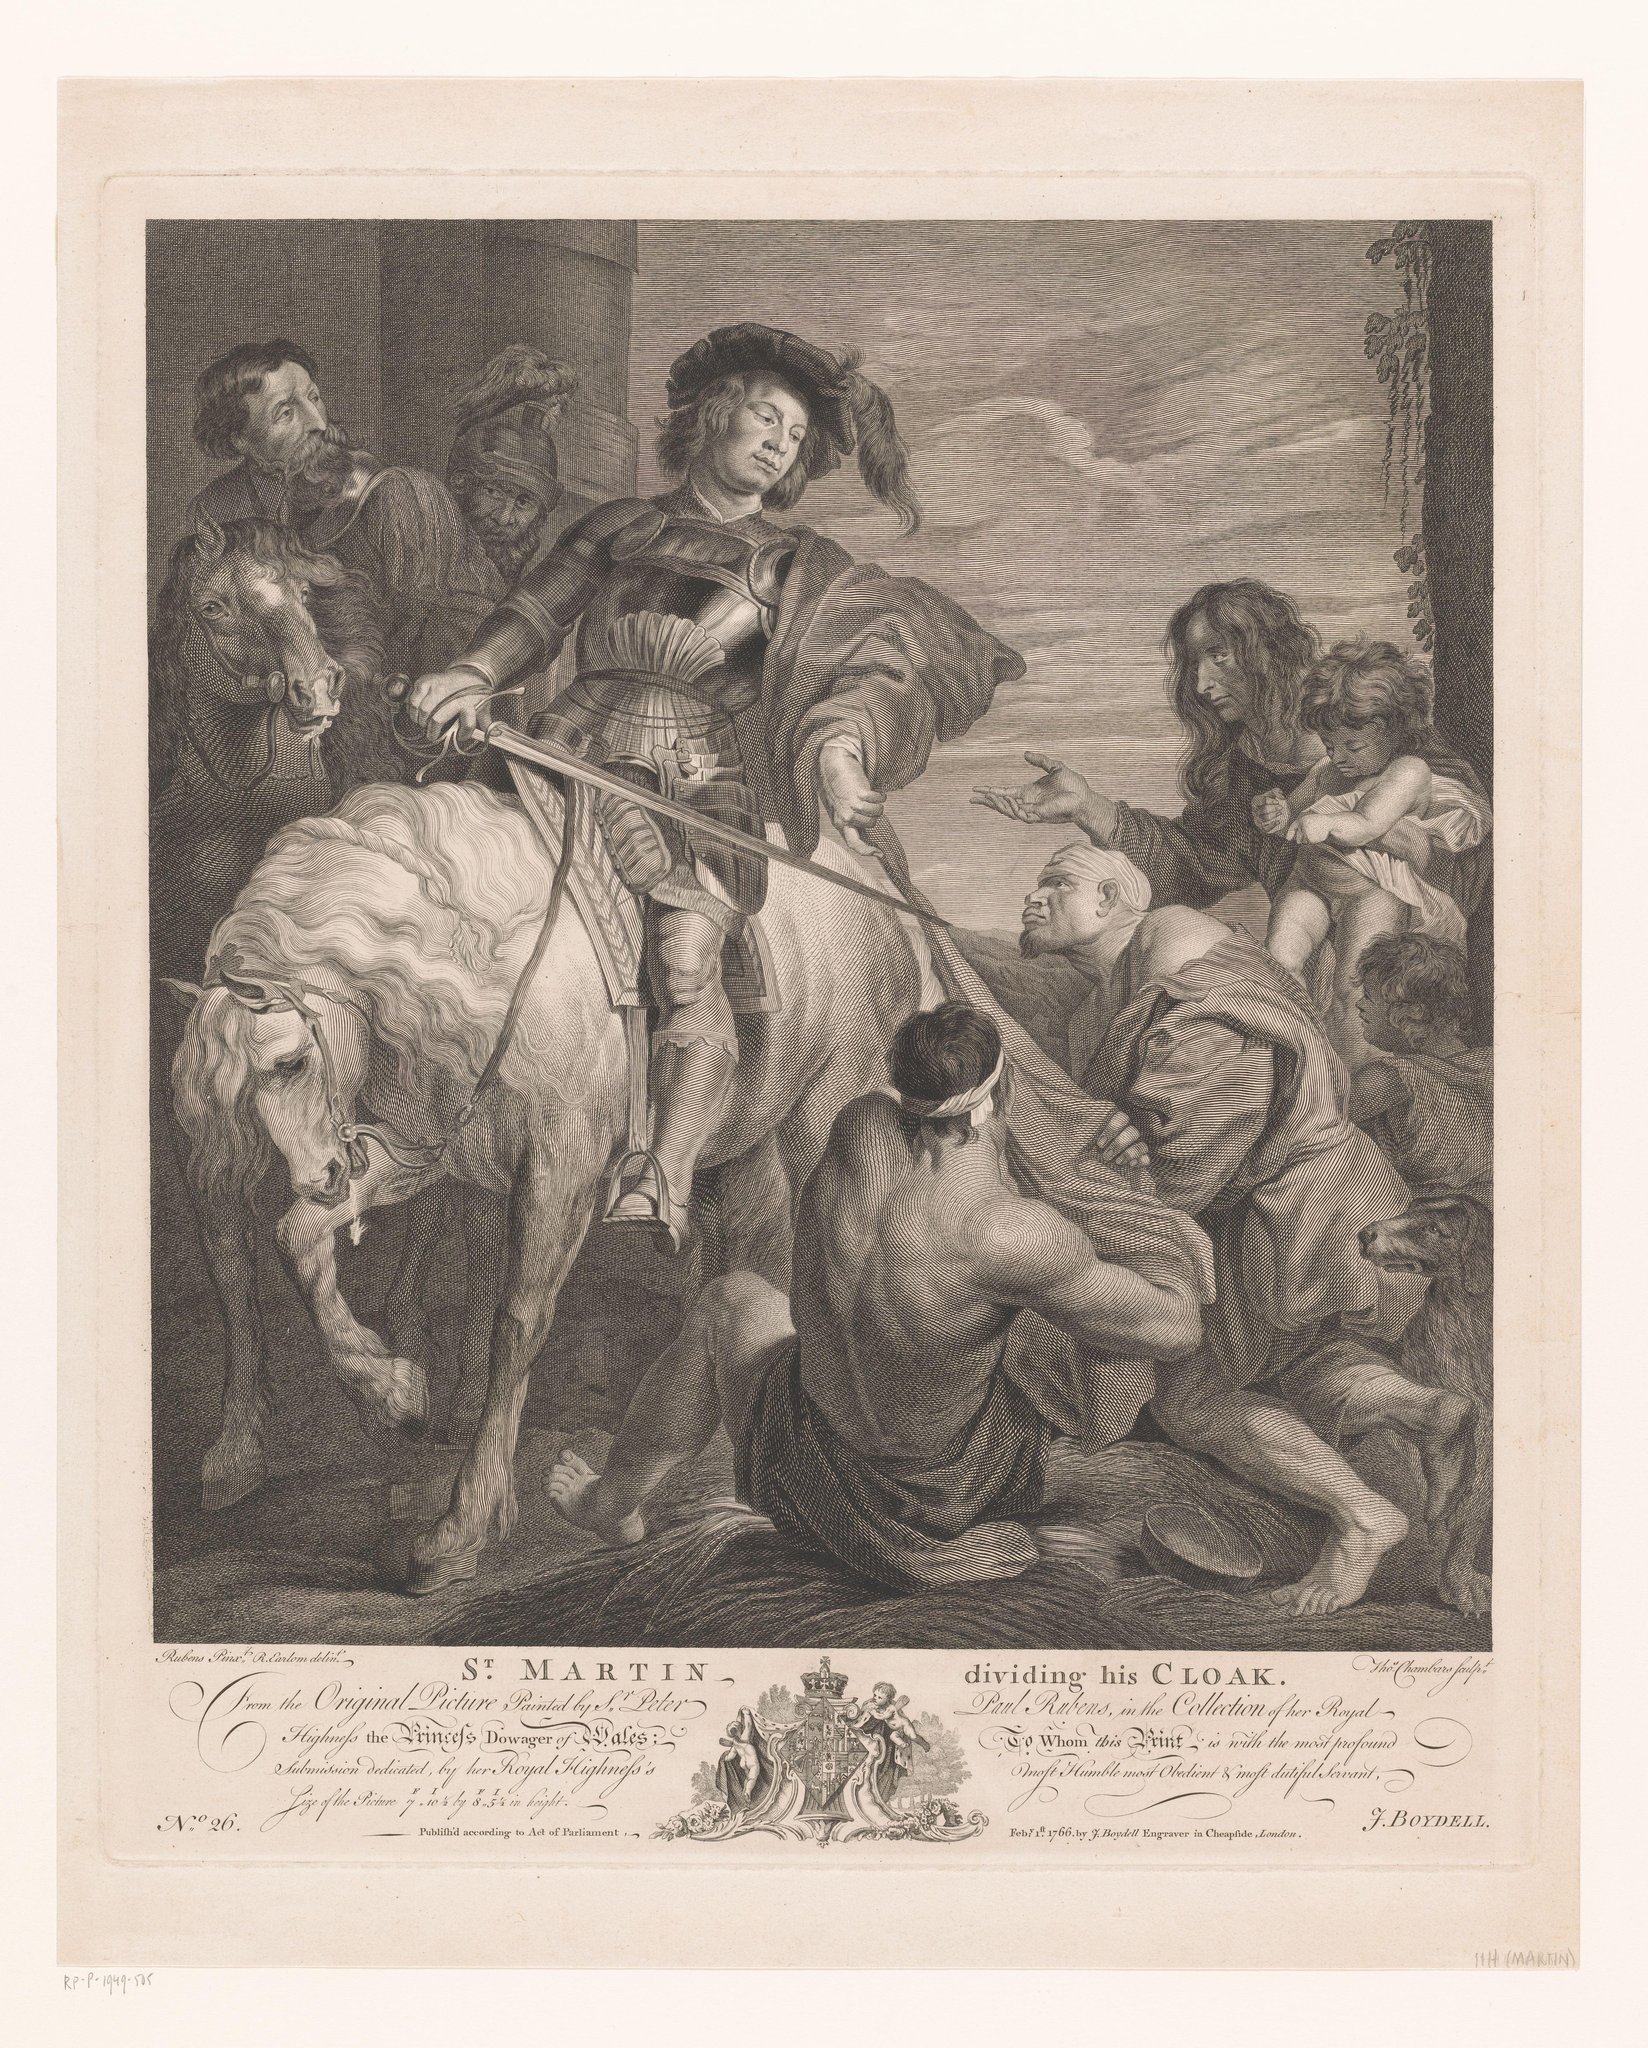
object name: print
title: Voornaamste schilderijen van Engeland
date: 1702-1766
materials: paper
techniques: engraving, etching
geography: london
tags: st. martin divides his cloak (i.e. the charity of st. martin): he is usually shown on horseback, cutting his cloak with his sword, or putting part of the cloak round the shoulders of a beggar who kneels beside him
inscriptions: collector's mark: Lugt 2228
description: Het schilderij is gemaakt door Anthony van Dyck en niet, zoals de prent vermeld, door Rubens. Vanaf 1763 tot 1786 publiceerde John Boydell prenten naar schilderijen uit Engelse collecties. Deze waren vanaf 1769 gebonden verkrijgbaar.